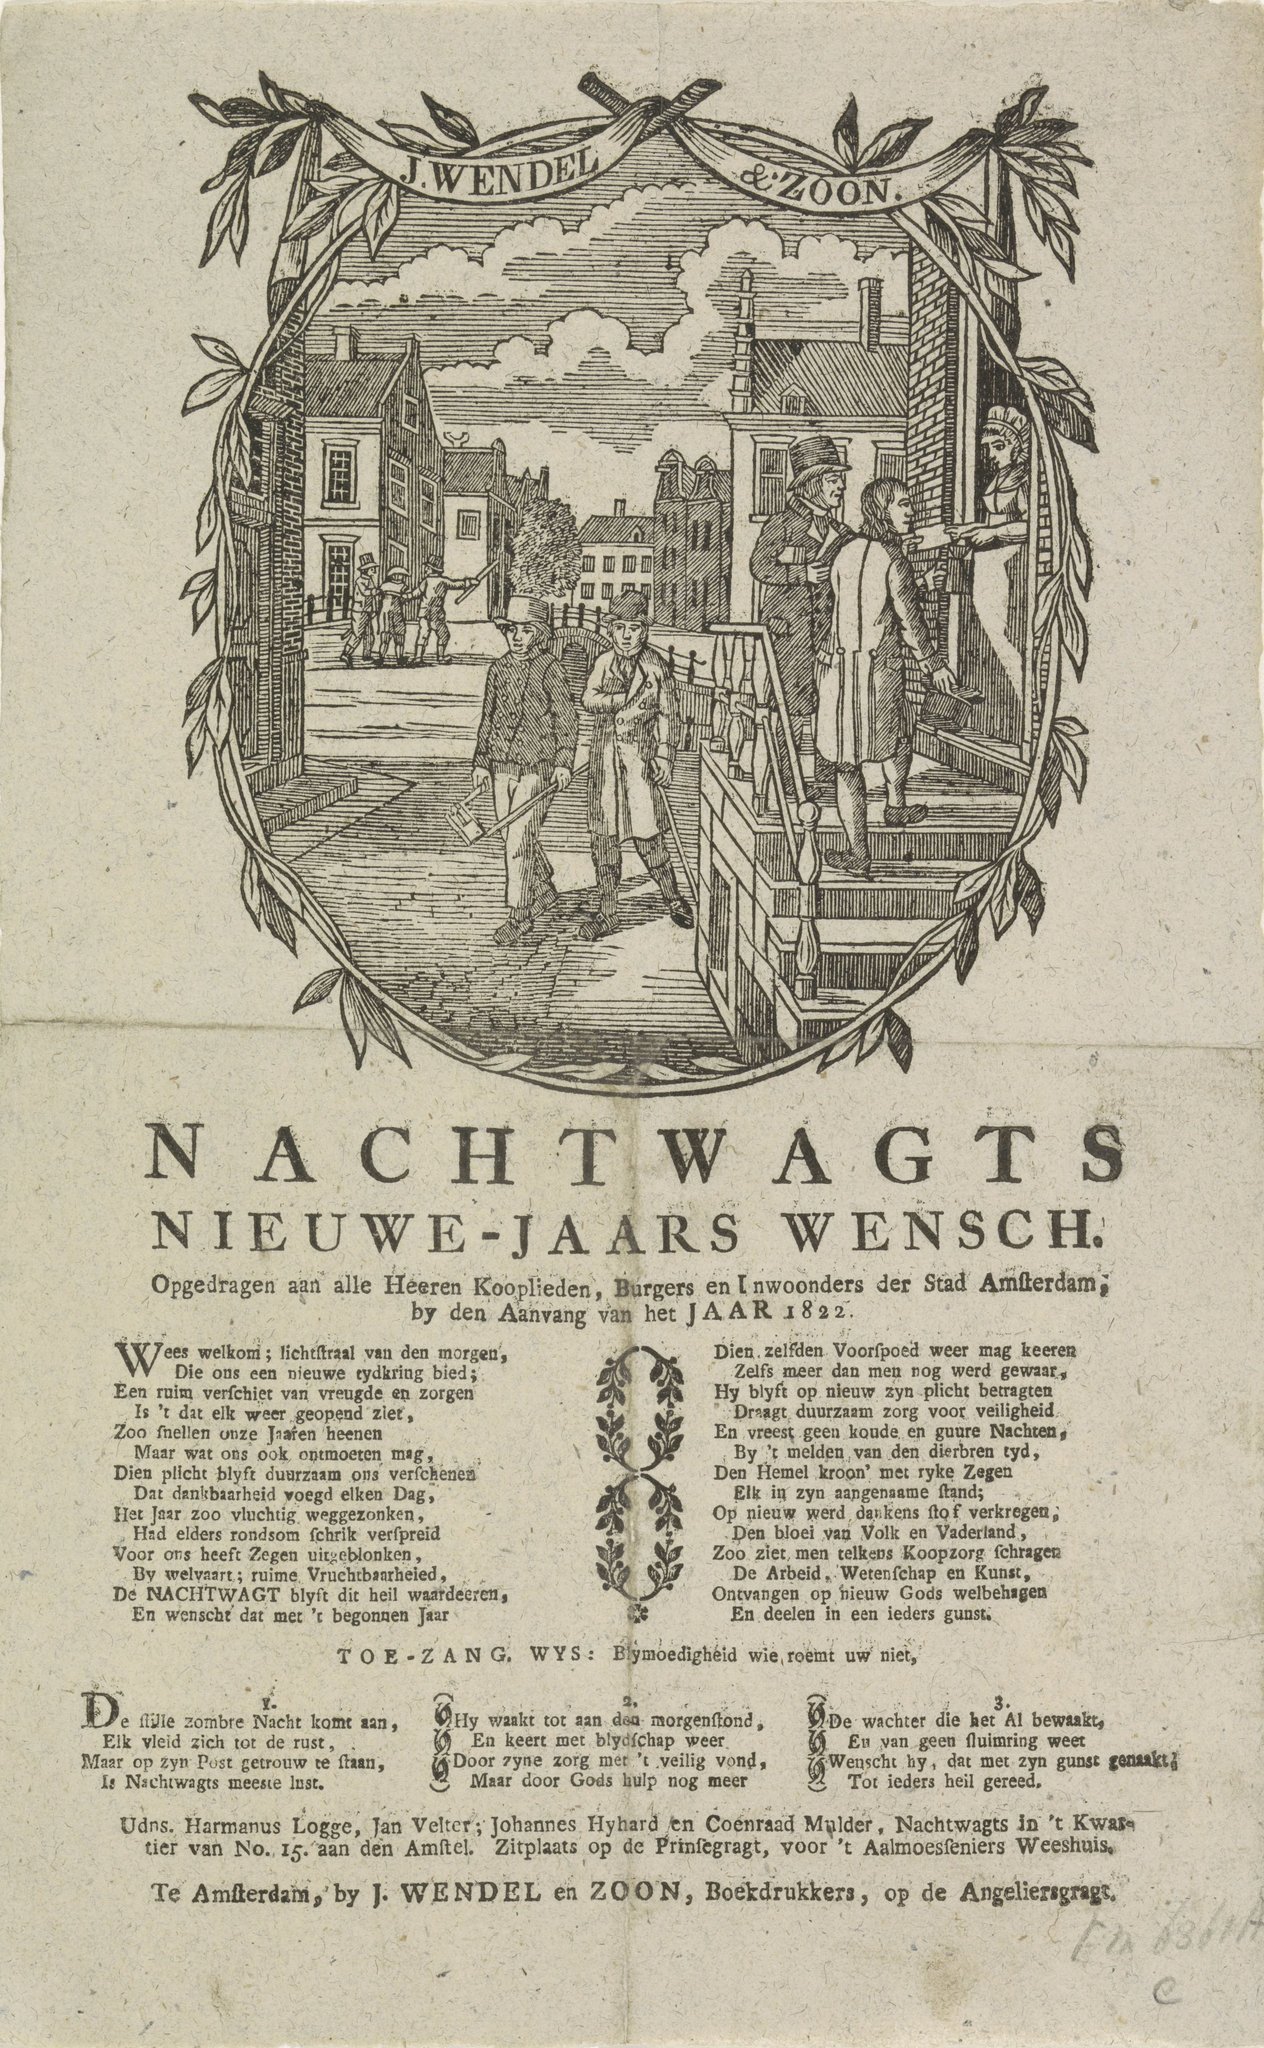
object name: new year card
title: Nachtwagts Nieuwe-jaars Wensch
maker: Anonymous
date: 1821-1822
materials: paper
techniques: letterpress printing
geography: netherlands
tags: night patrol, street, amsterdam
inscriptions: collector's mark: Lugt 2228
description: Nieuwjaarswens van de Amsterdamse nachtwacht (ratelwacht) voor het jaar 1822. Ovale voorstelling versierd met lauwerbladen. Enkele mannen lopen met ratels door de straten, twee mannen halen geld op bij een huis. Met een vers in twee kolommen en een lied in drie coupletten. Namens de nachtwacht in kwartier No. 15 aan de Amstel: Harmanus Logge, Jan Velter, Johannes Hyhard en Coenraad Mulder.